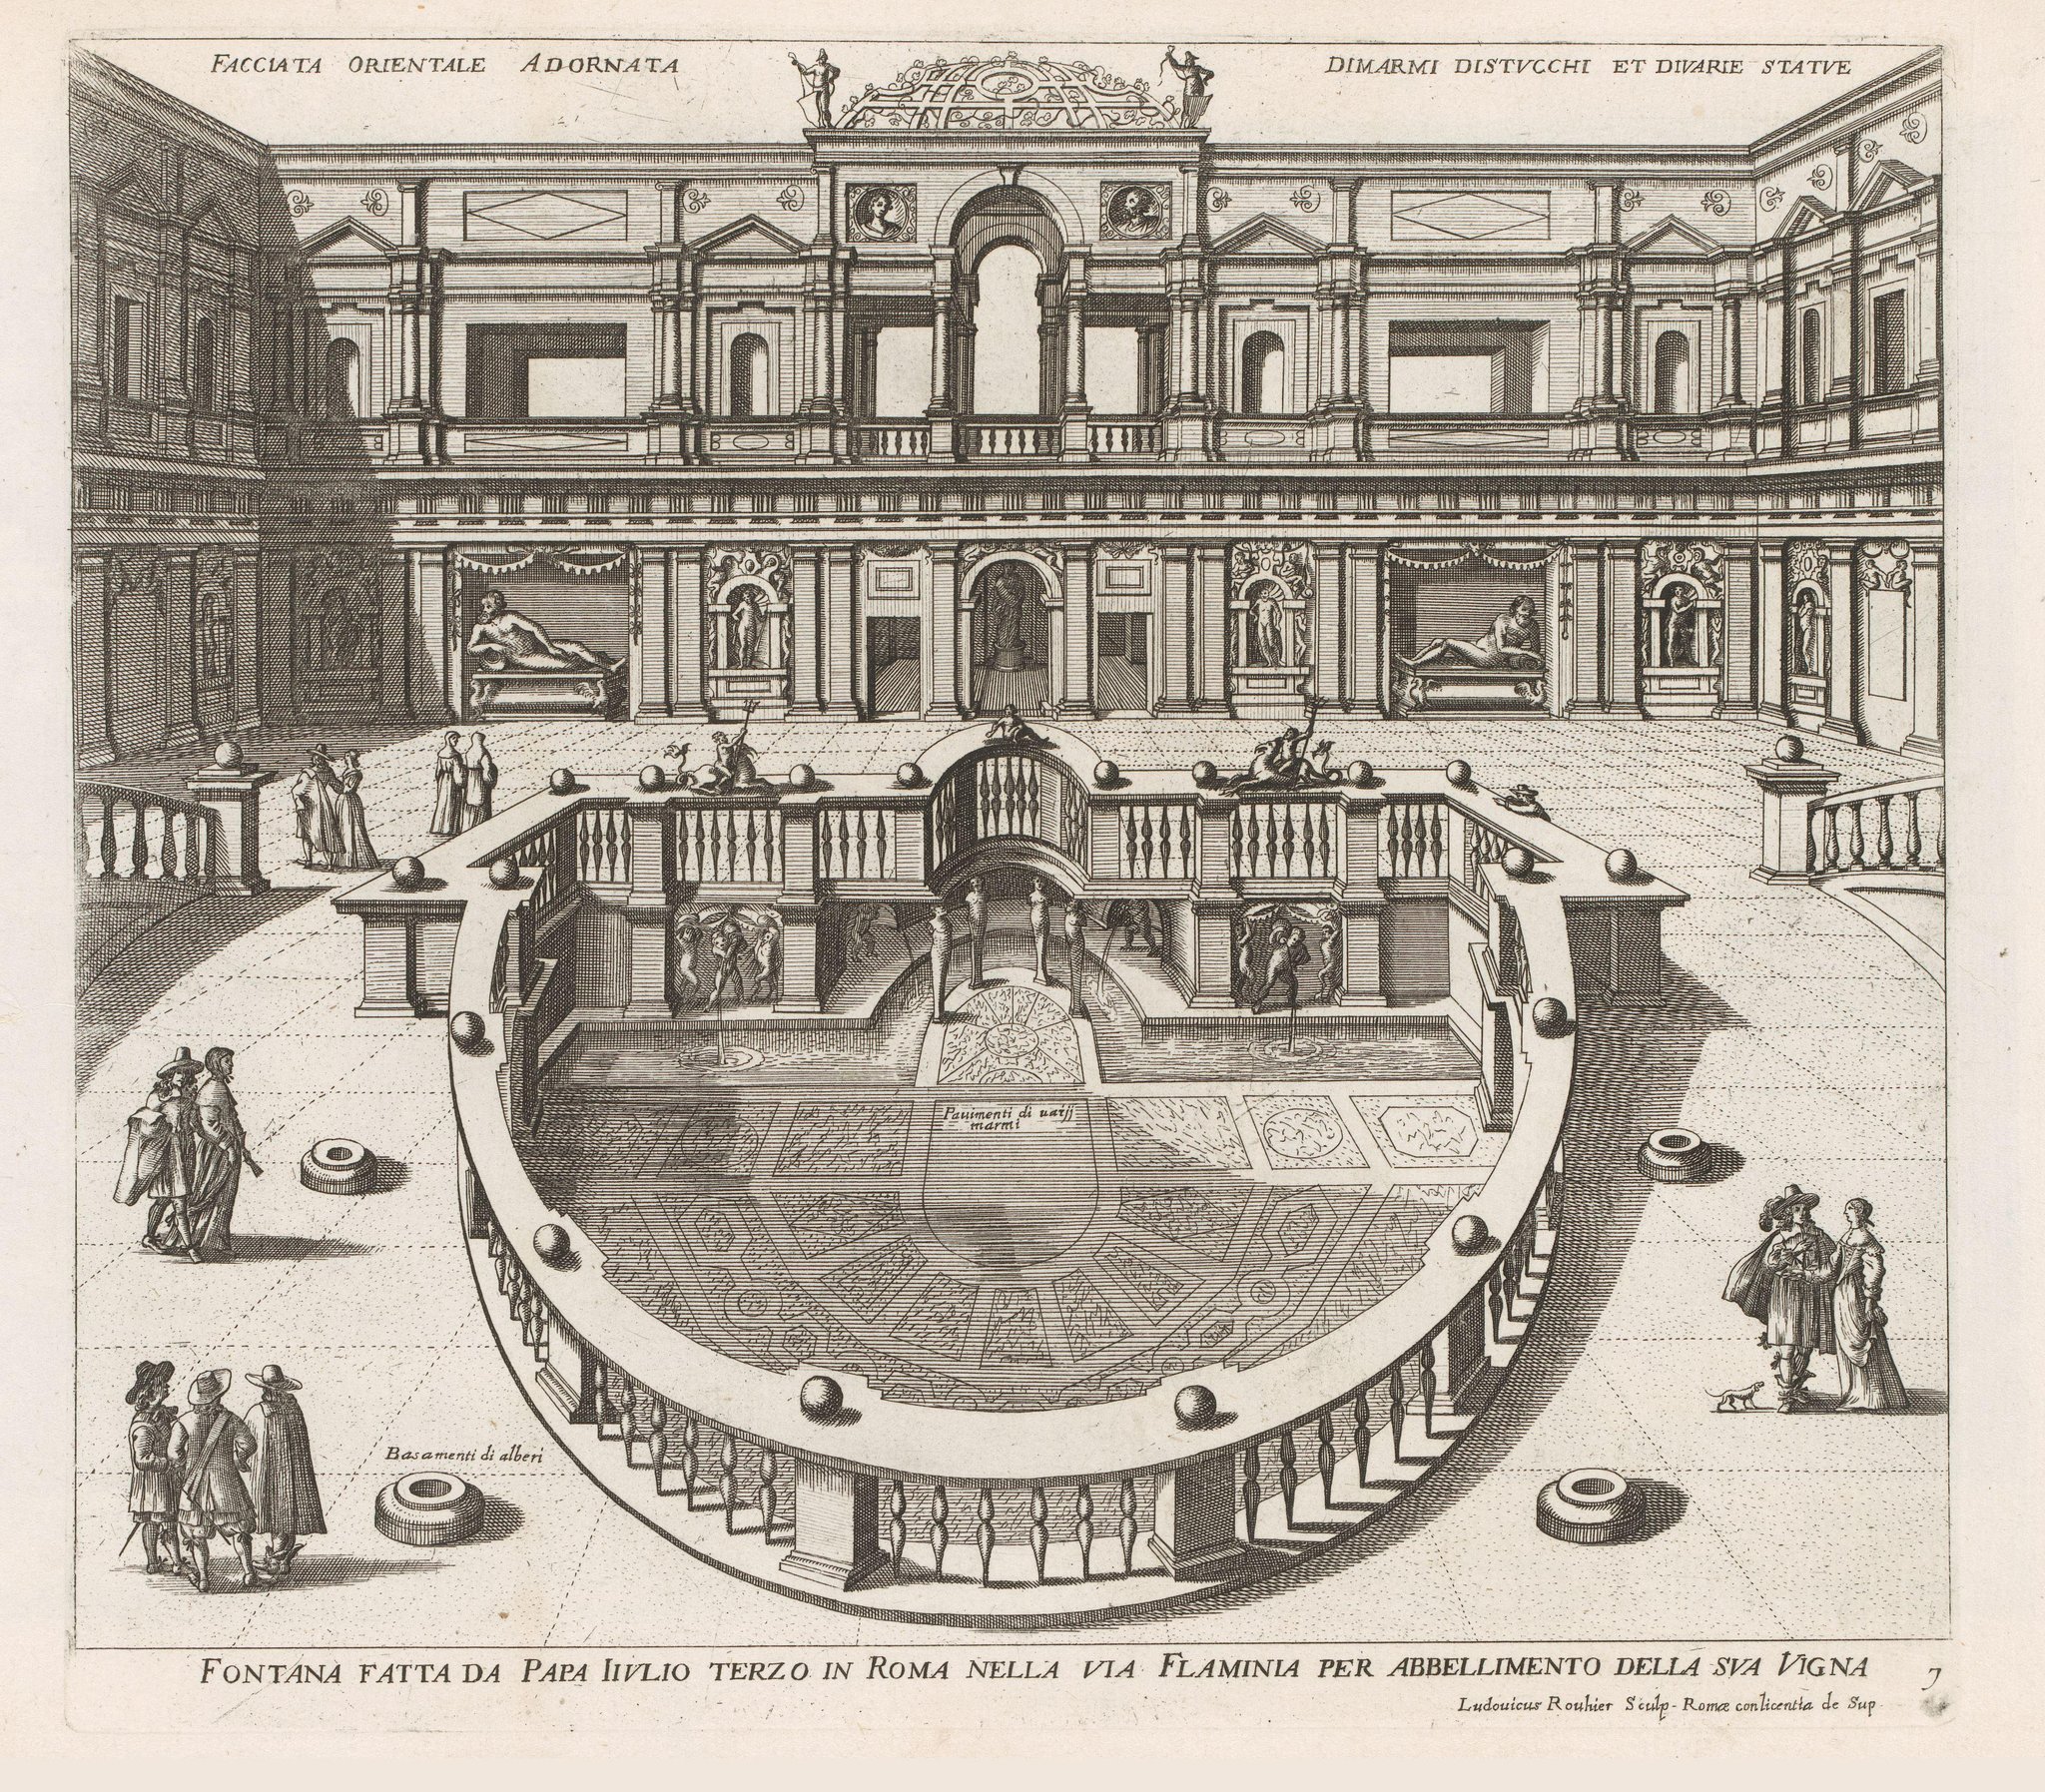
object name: album leaf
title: Nymphaeum in de Villa Giulia te Rome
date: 1653-1691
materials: paper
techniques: etching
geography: vatican city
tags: caryatids ~ architecture, courtyard, ornamental fountain, rome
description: Binnenplaats van de Villa Giulia met in het midden een nymphaeum, een aan nimfen gewijd monument, gebouwd door paus Julius III. Genummerd rechtsonder: 7. De prent maakt deel uit van een album.